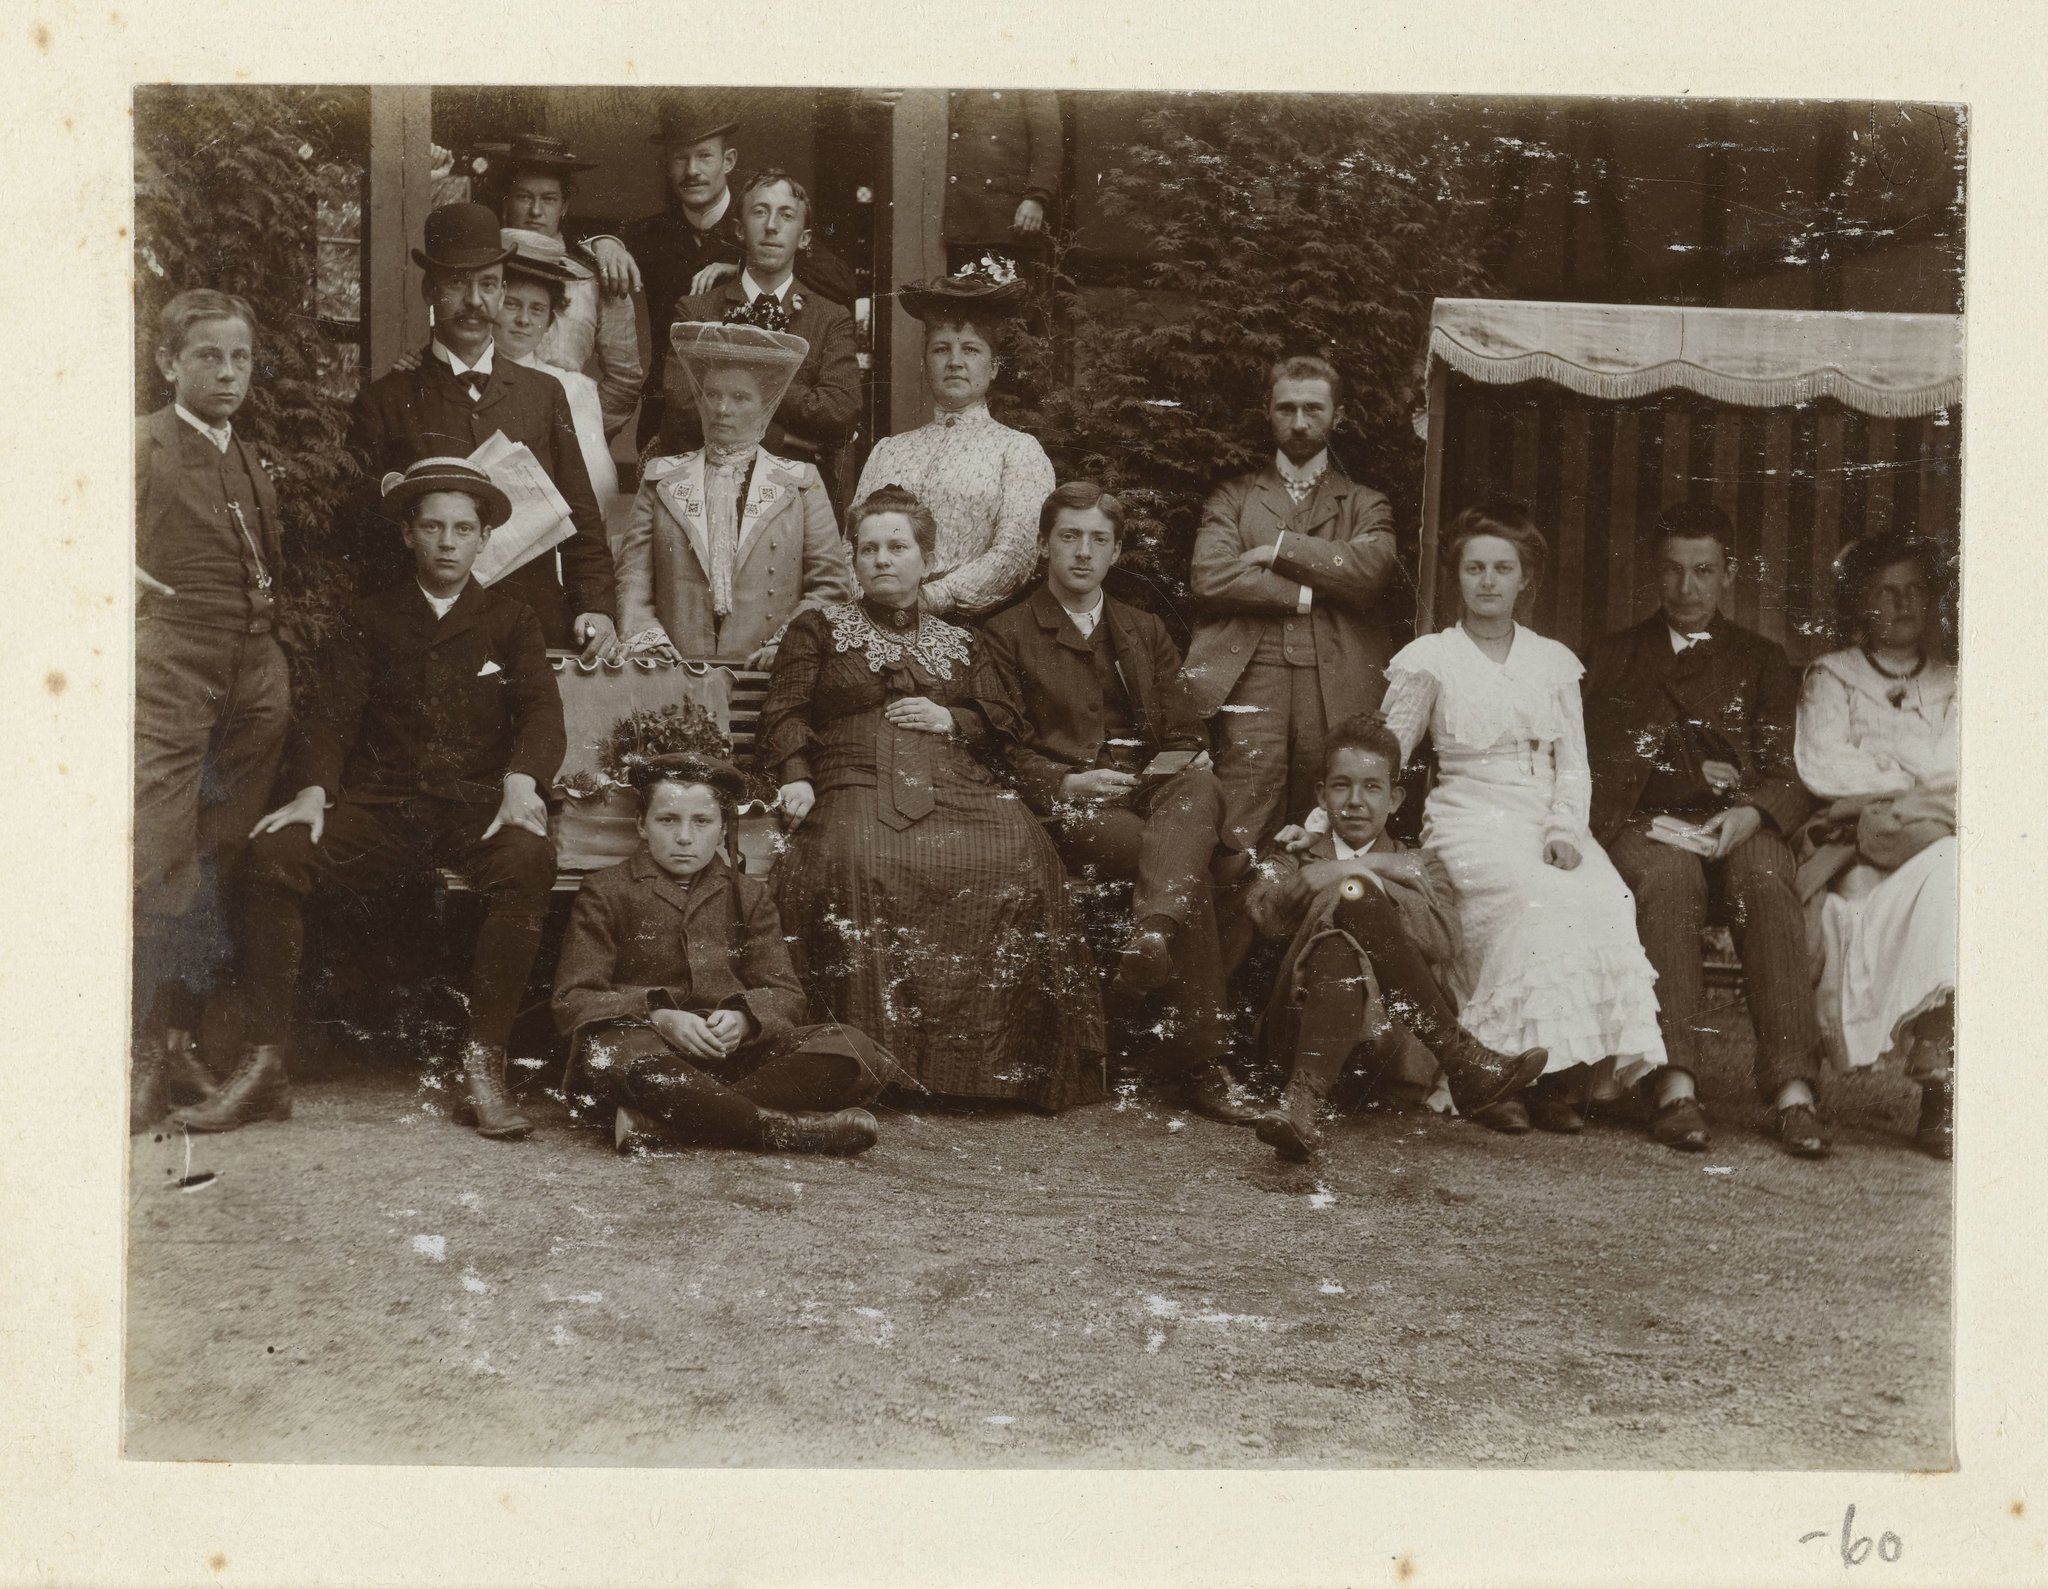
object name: photograph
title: Portret van de families Kessler en Heyning tijdens een vakantie in de Harz, helemaal links Dolph Kessler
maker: geldolph adriaan kessler (dolph)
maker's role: fotograaf, industrieel, voetballer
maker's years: 1884-1945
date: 1903-1908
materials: cardboard, photographic support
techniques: gelatin silver print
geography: harz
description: Portret van de families Kessler en Heyning vermoedelijk tijdens een vakantie in de Harz voor een Gasthof of hotel. Onderdeel van het fotoalbum van Dolph Kessler met opnamen die hij maakte tijdens zijn verblijf in Engeland en op een wereldreis die hij als secretaris van Henri Deterding (directeur Koninklijke Olie) ondernam naar Nederlands-Indië, Japan, China en de Verenigde Staten, tussen 1906 en 1908.